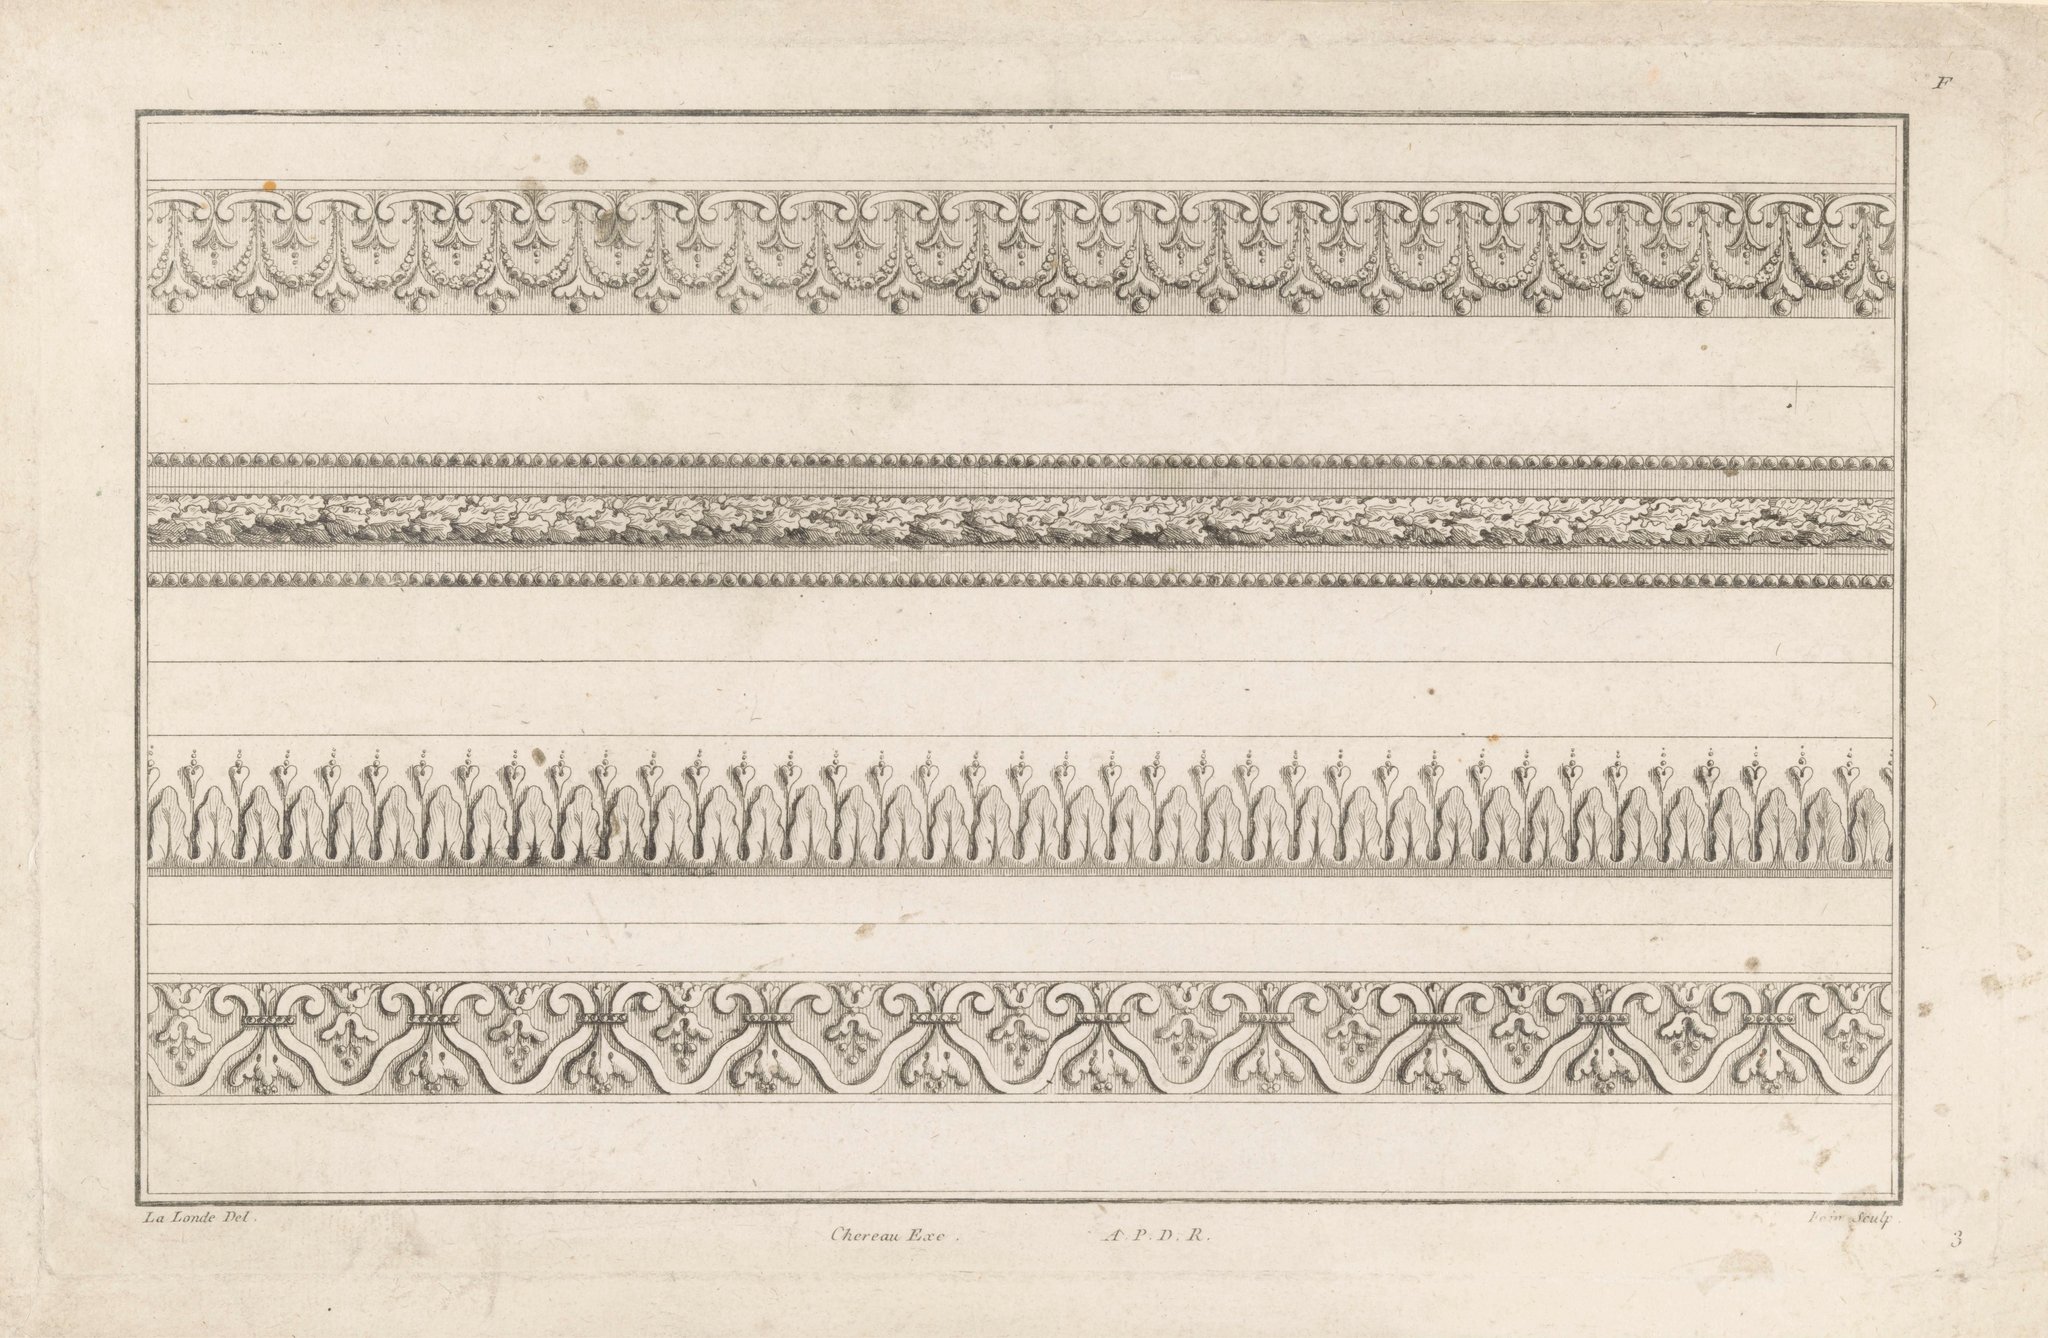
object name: print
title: Vier randen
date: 1784-1785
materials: paper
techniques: engraving, etching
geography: paris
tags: ornaments ~ art (+ framing decorations)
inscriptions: collector's mark: Lugt 2228, collector's mark: Lugt 2760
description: Vier geornamenteerde randen met vlechtwerk en bladmotieven.